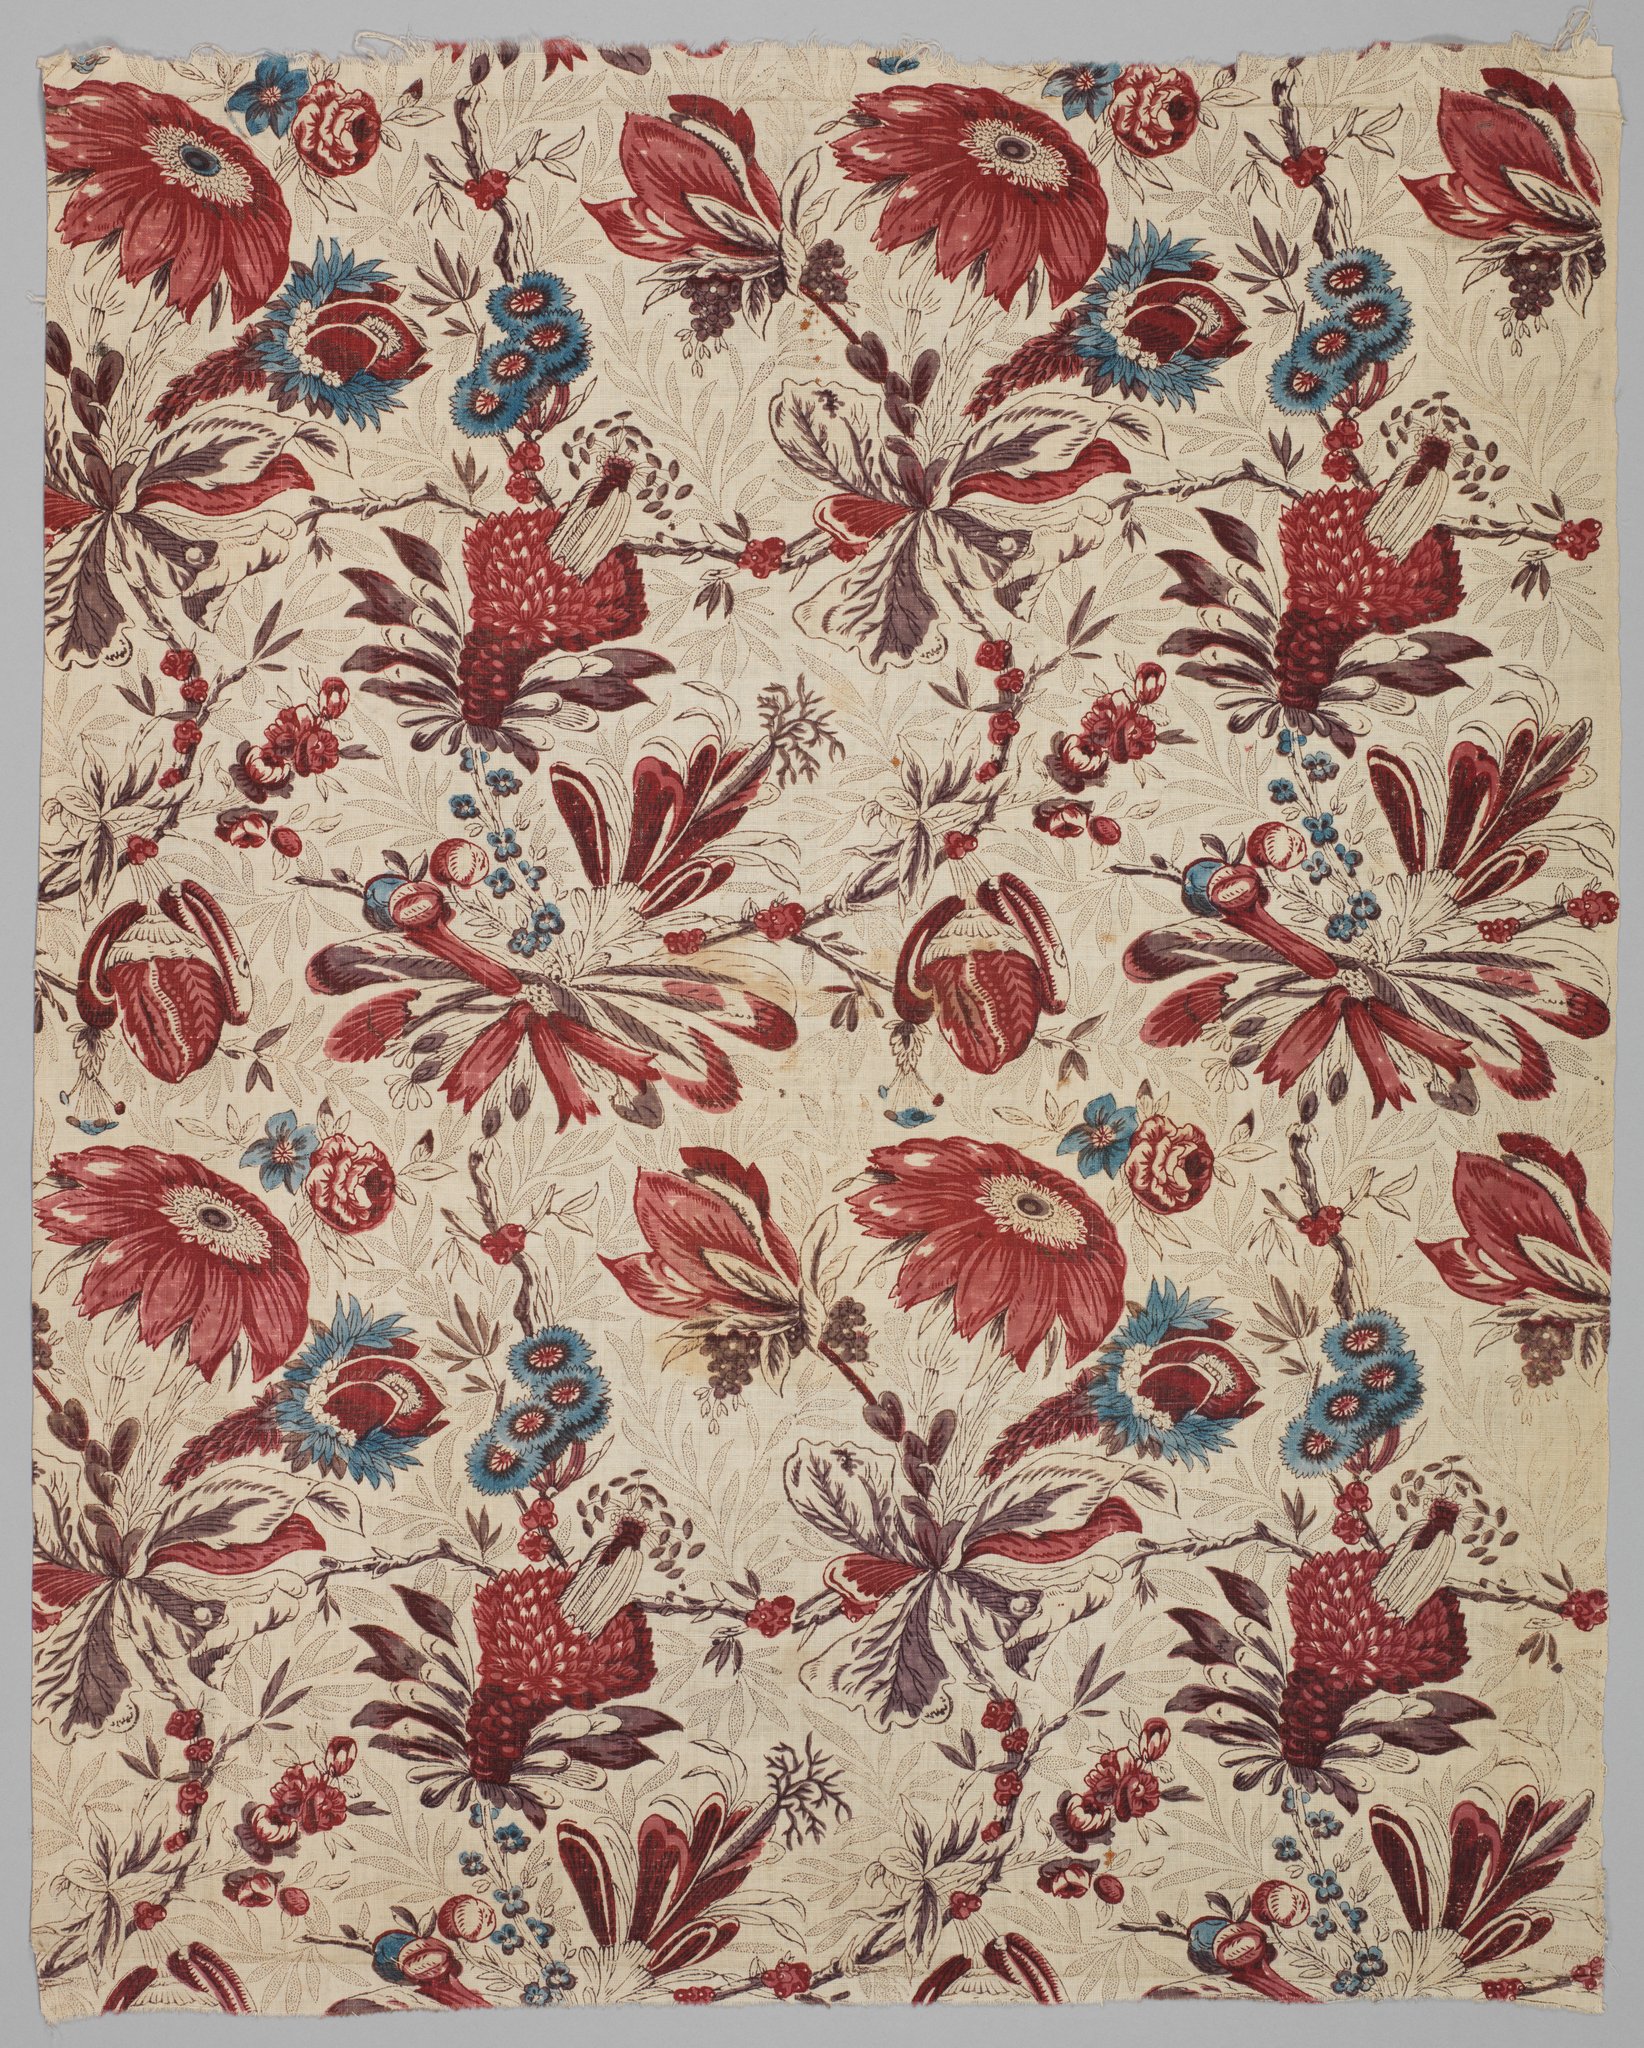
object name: piece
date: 1850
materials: cotton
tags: flowers